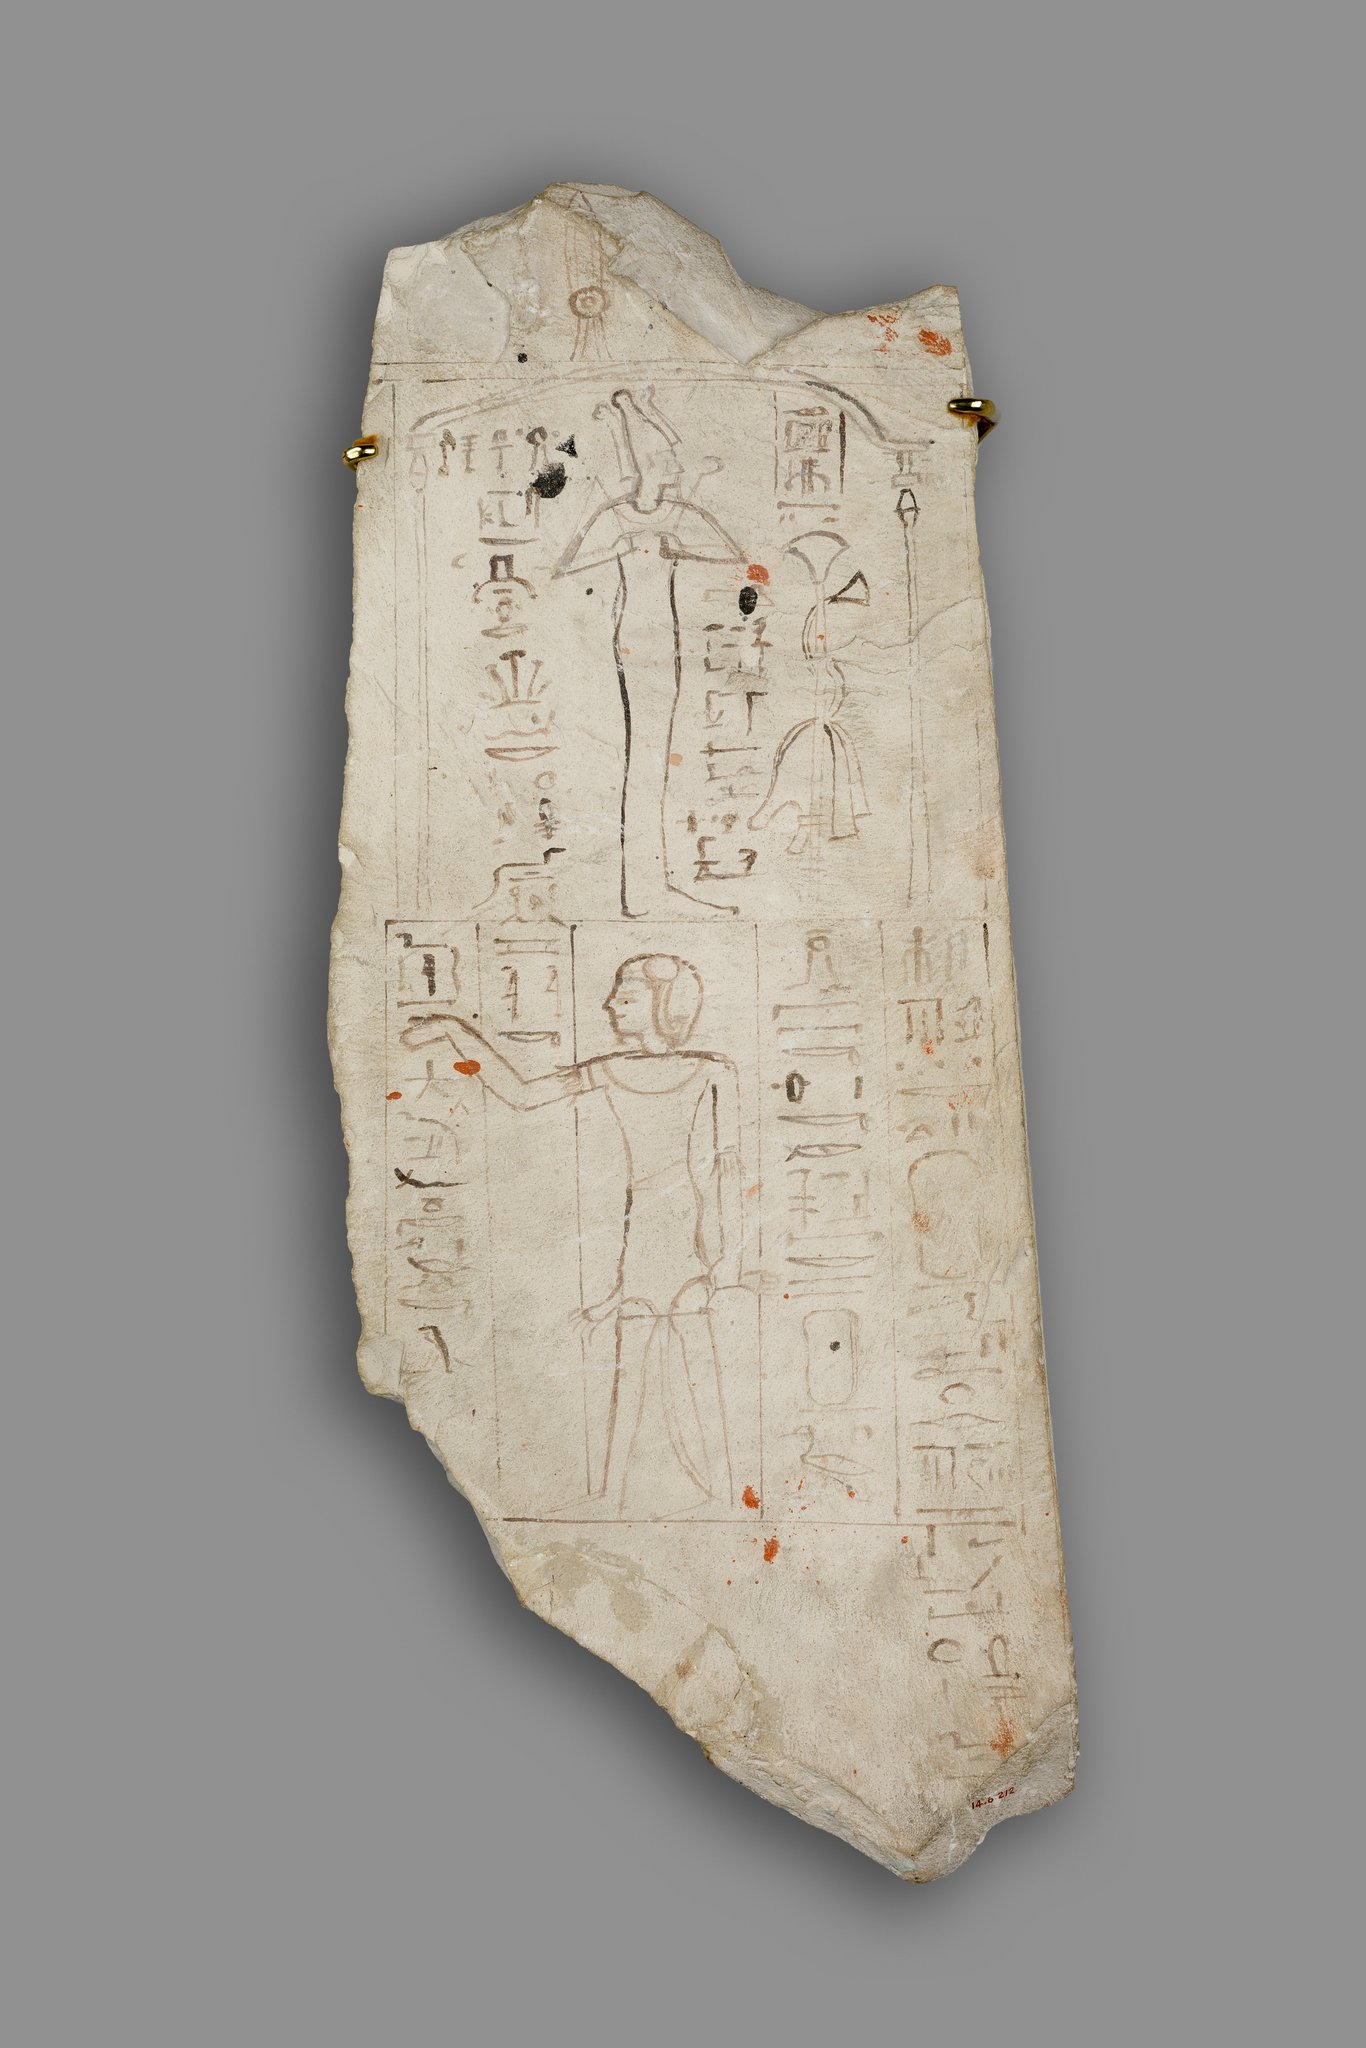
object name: ostracon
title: Ostracon with a figure of the god Iunmutef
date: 1295-1070 BCE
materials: ink, limestone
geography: egypt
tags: human figures,hieroglyphs